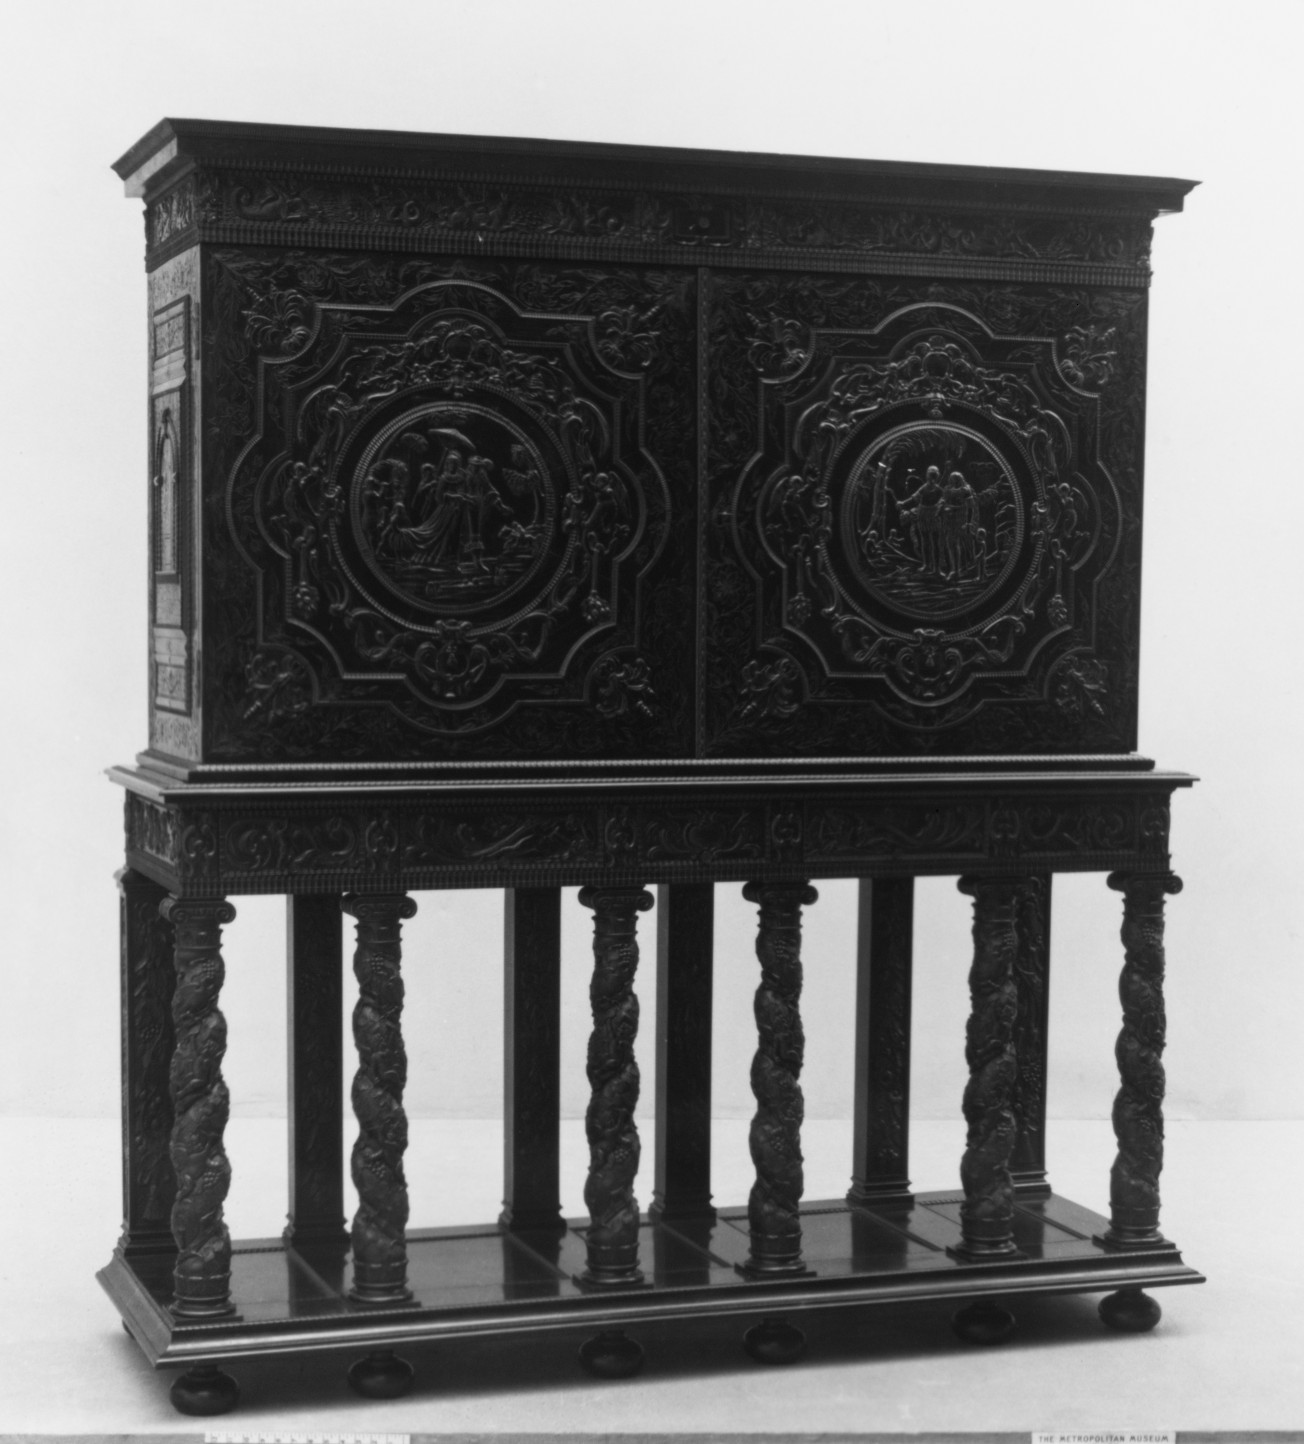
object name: cabinet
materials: bone, wood